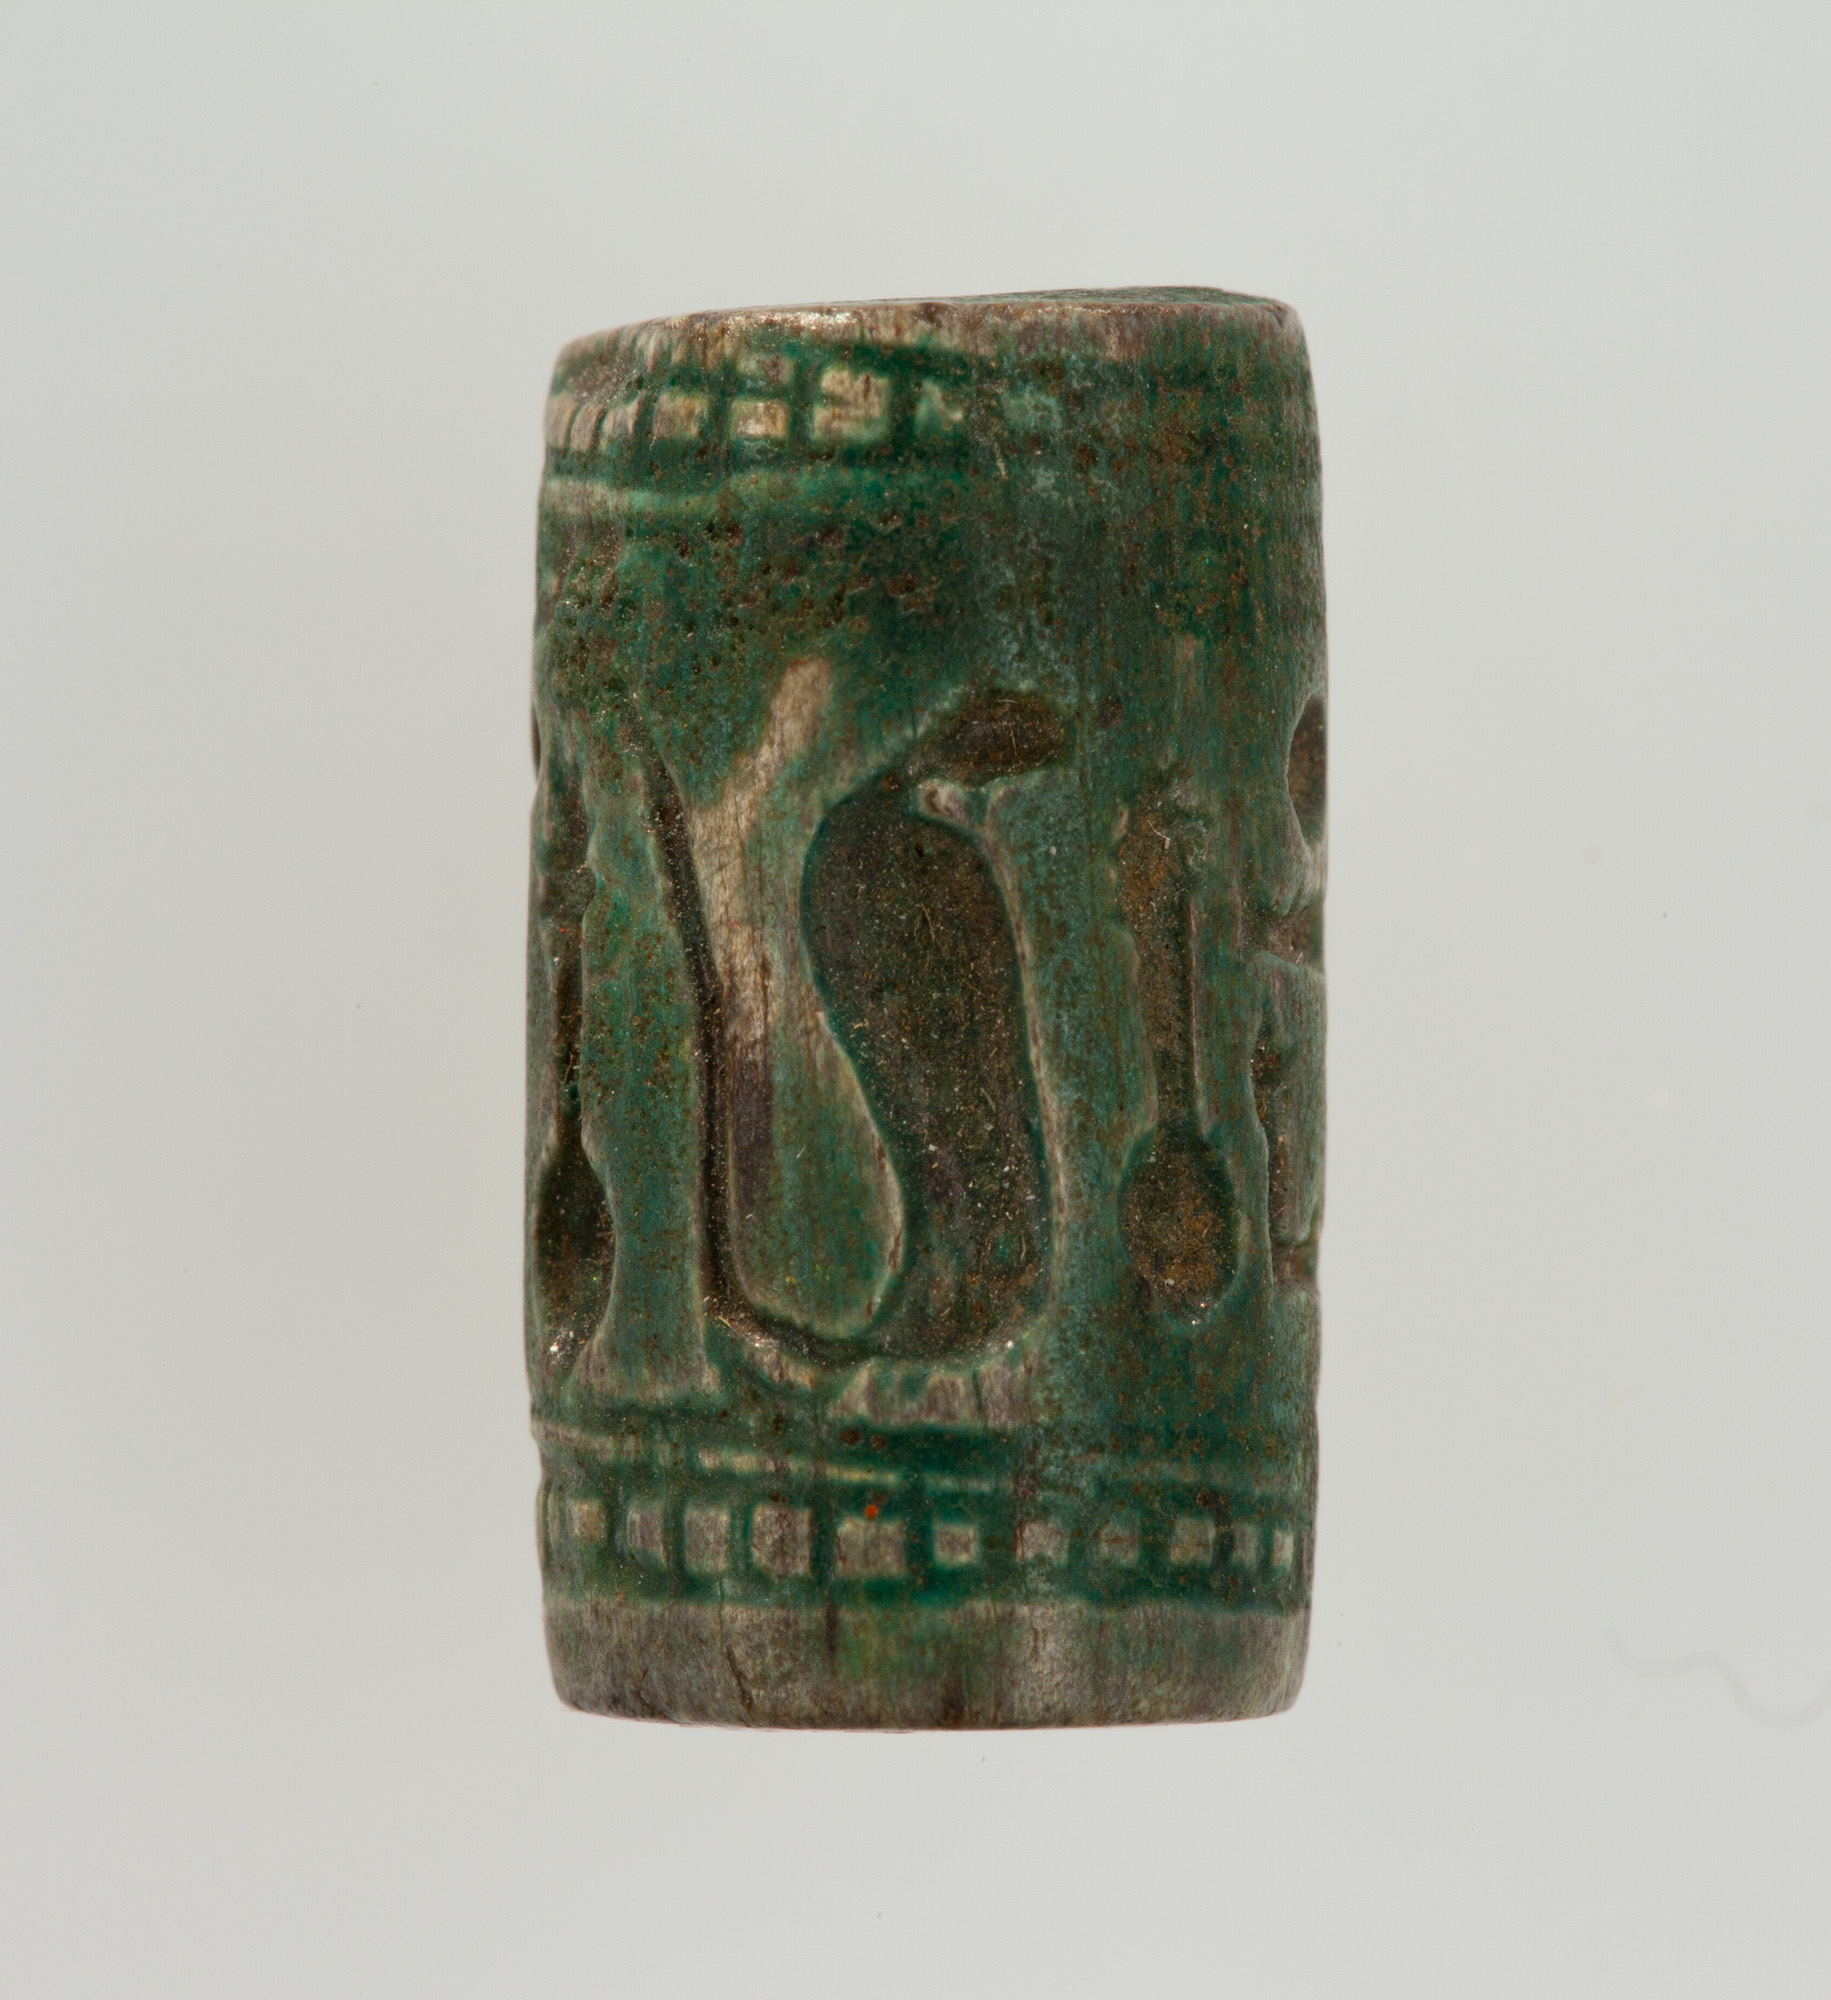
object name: cylinder seal, amenhotep i, djeserkare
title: Cylinder Seal Inscribed with the Throne Name of Amenhotep I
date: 1492-1479 BCE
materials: stone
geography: egypt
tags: hieroglyphs,scarabs